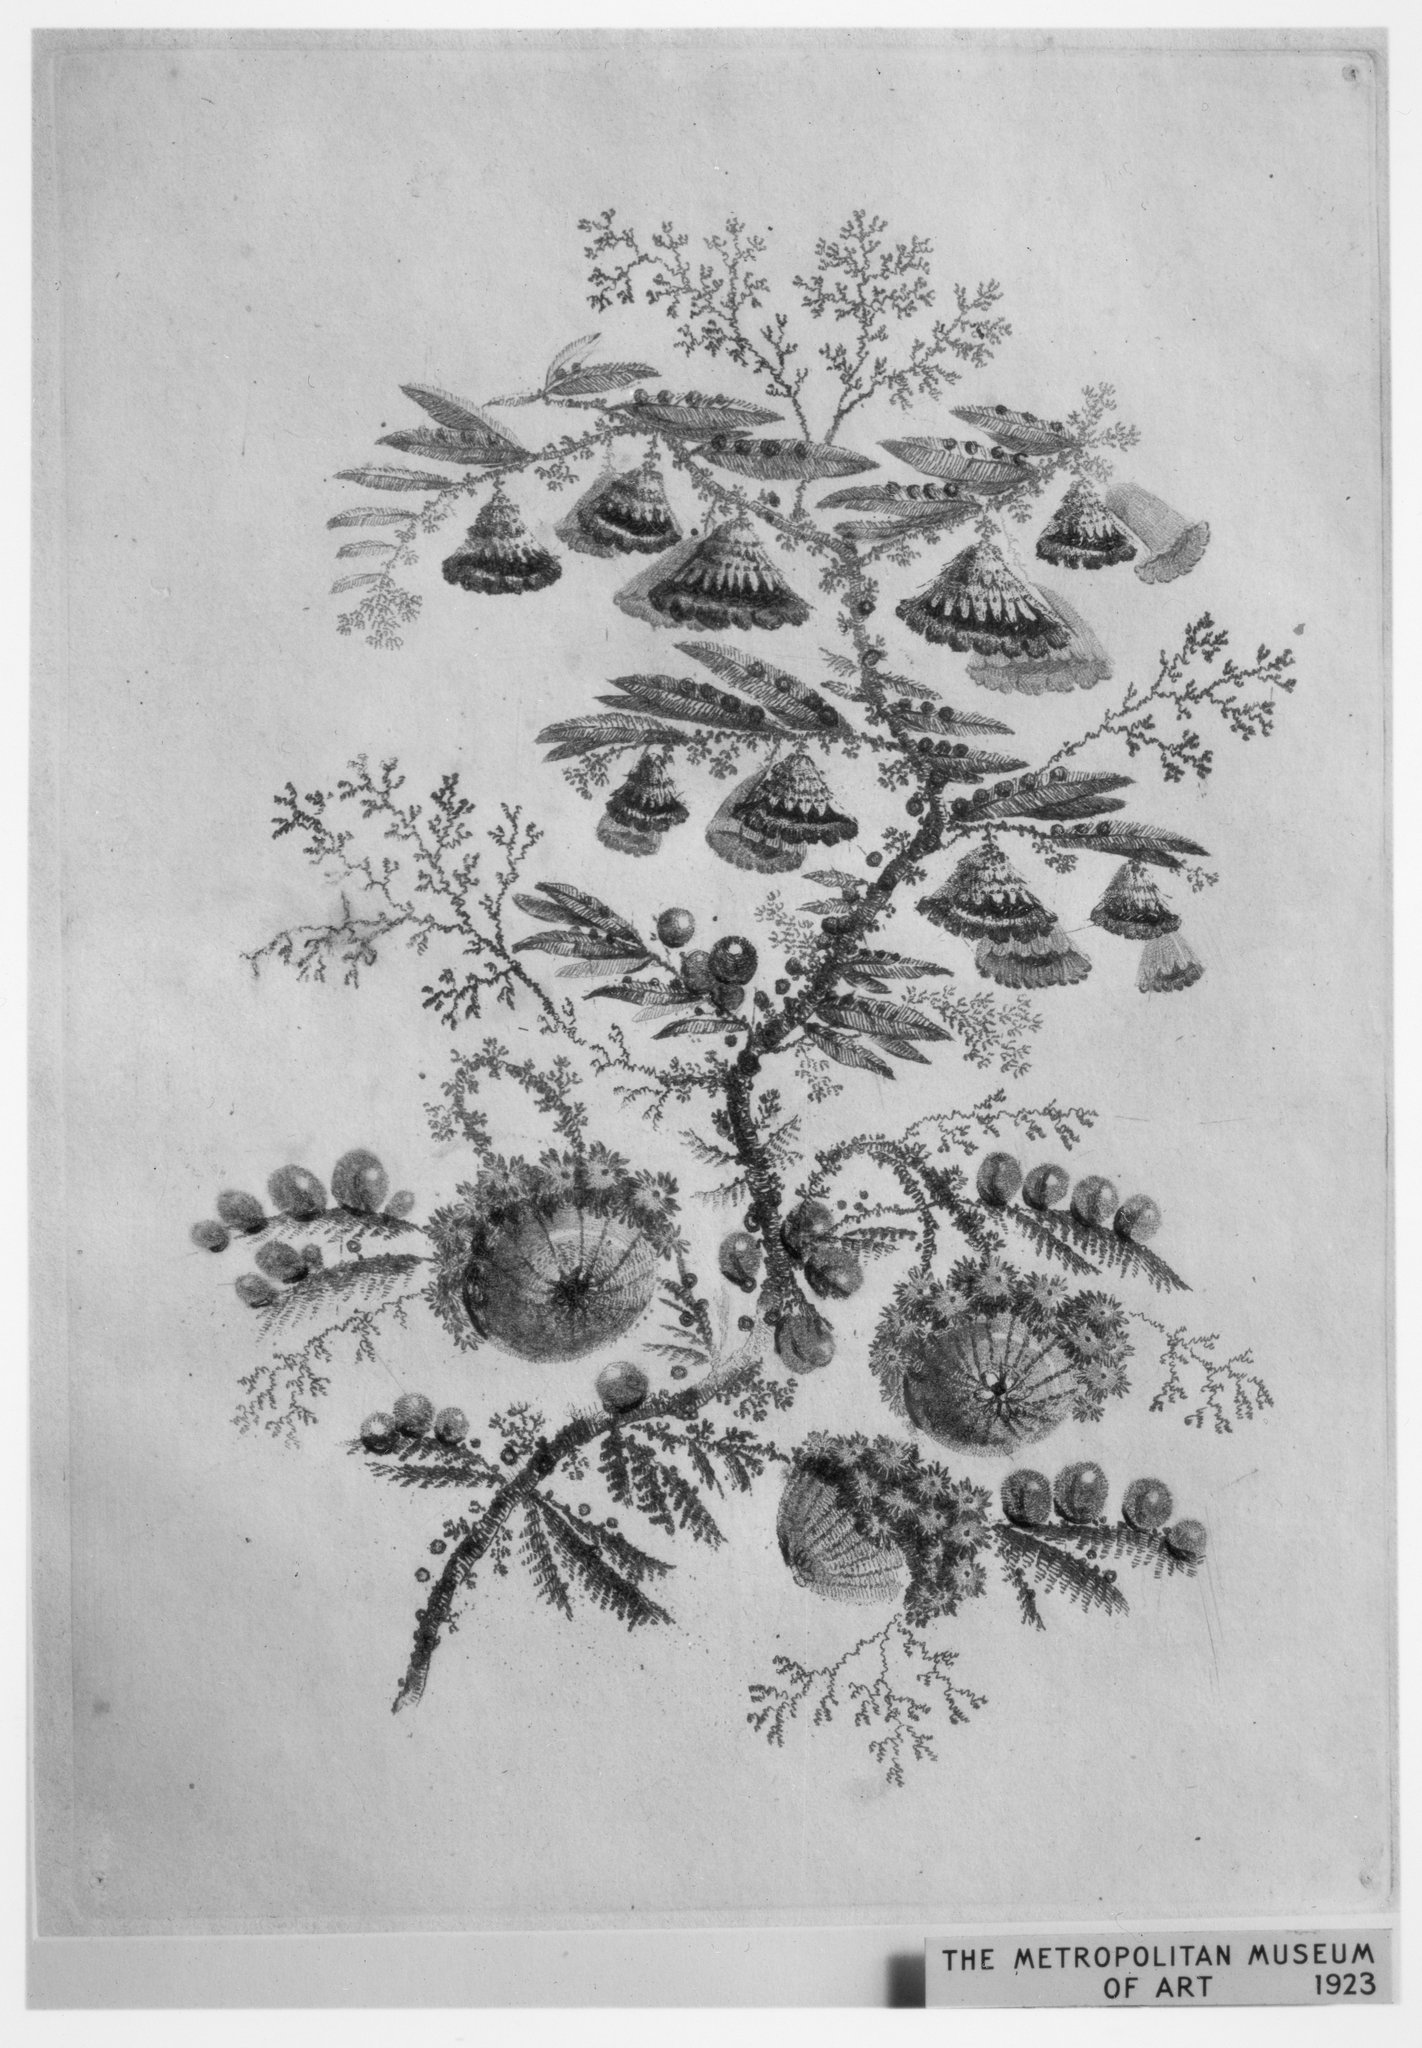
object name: print ornament architecture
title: Flowers from "Nouvelle Suite de Cahiers de fleurs ideales a l'usage des dessinateurs et des peintres" (Nr 1)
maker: jean pillement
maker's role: artist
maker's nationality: french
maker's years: 1728-1808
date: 1790-1799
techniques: etching, lithography